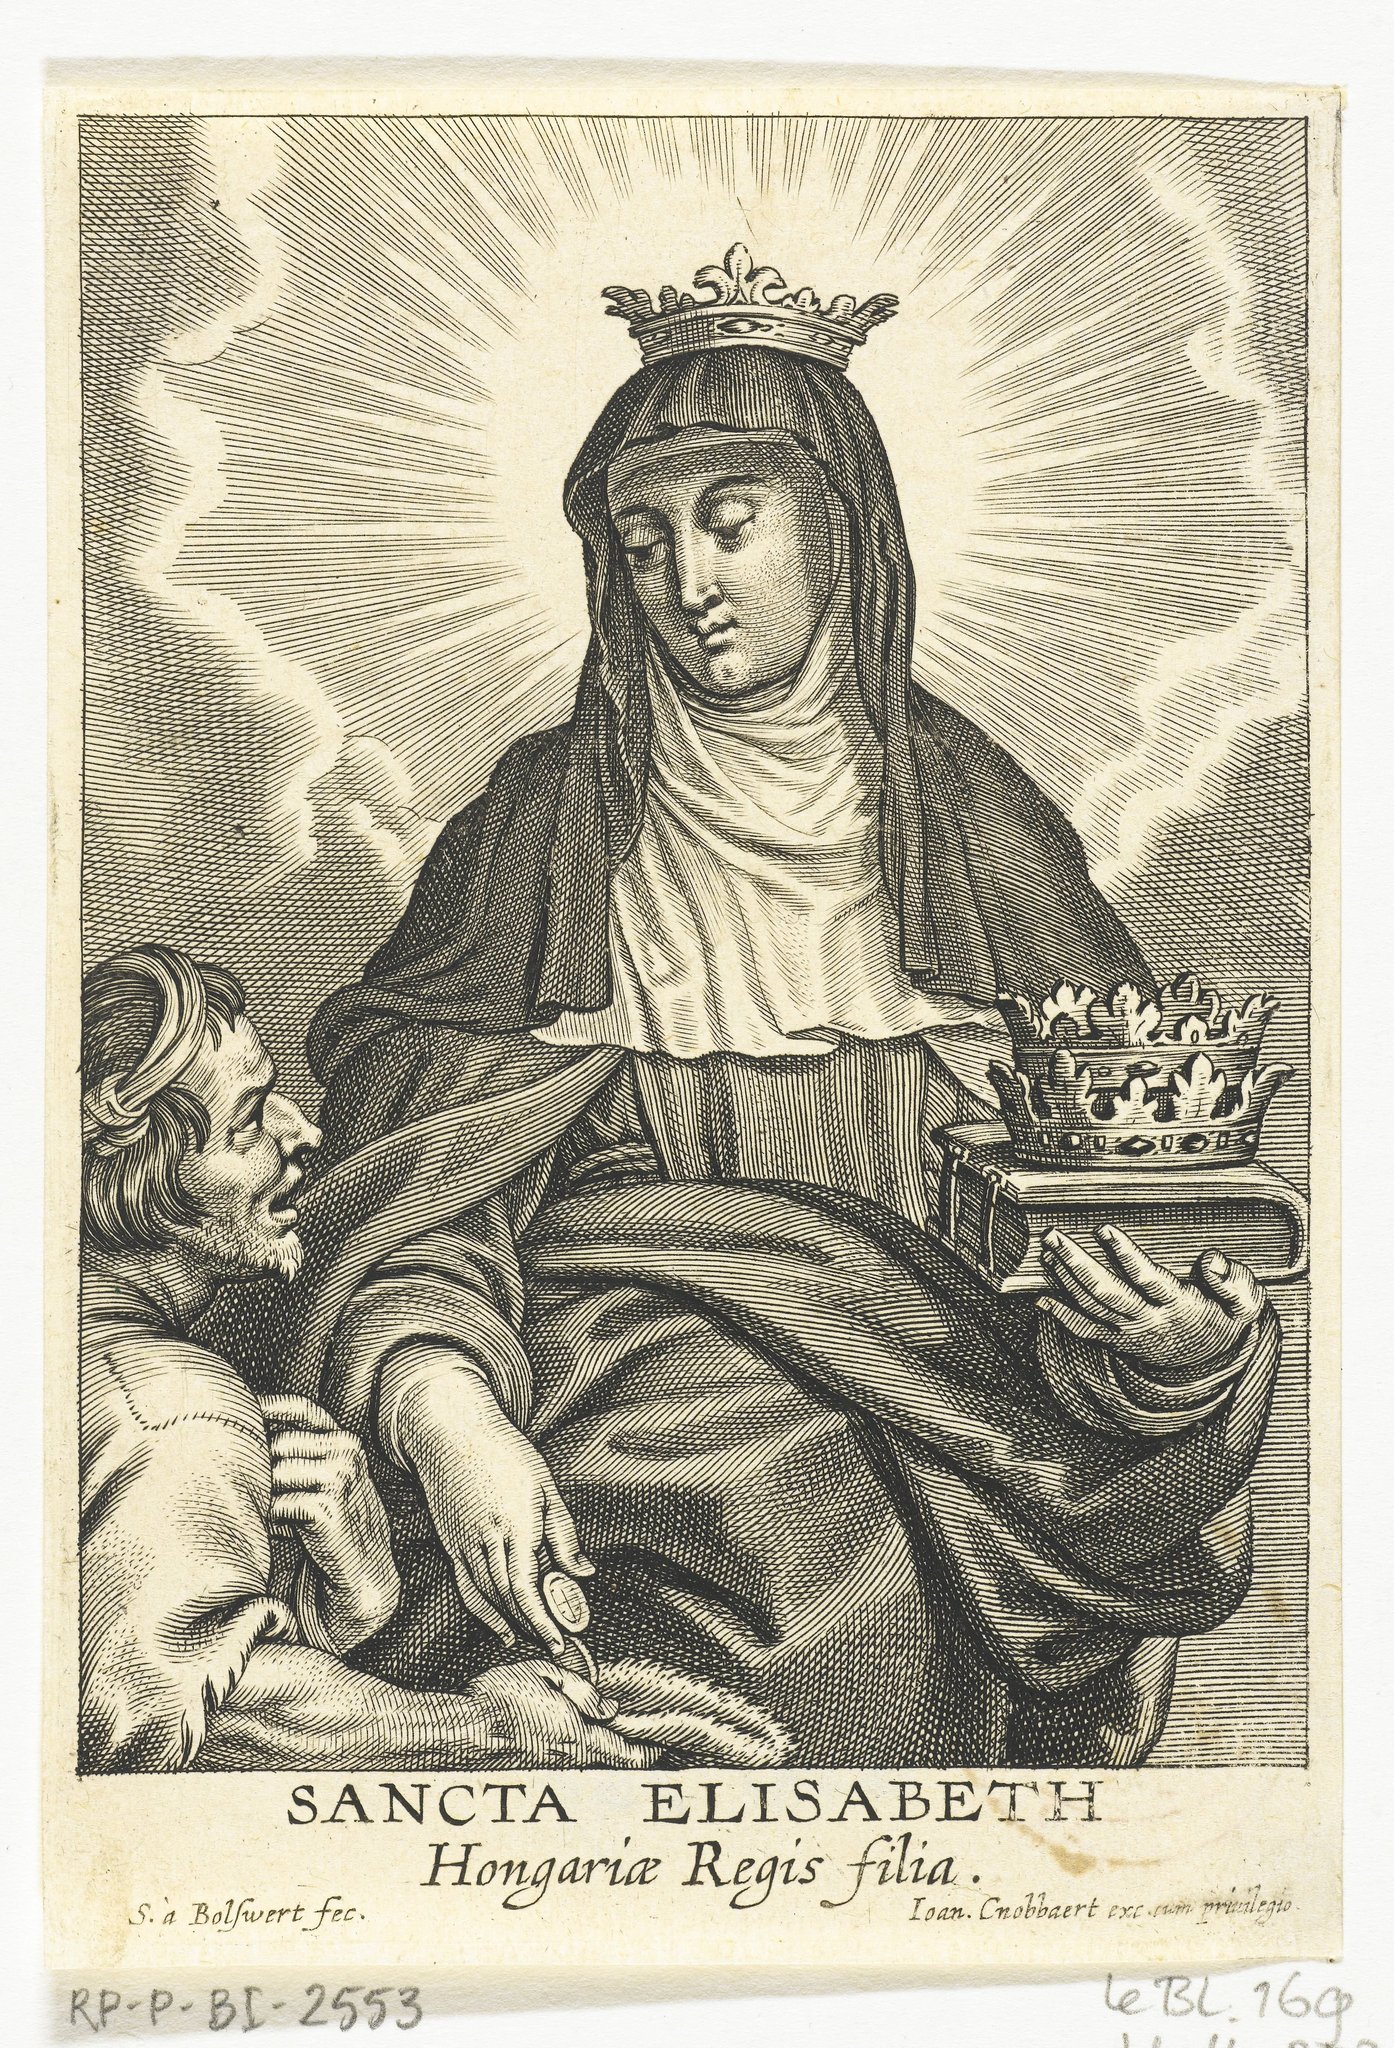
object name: print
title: Heilige Elisabeth van Hongarije geeft aalmoes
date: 1596-1659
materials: paper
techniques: engraving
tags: st. elisabeth giving alms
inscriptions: collector's mark: Lugt 240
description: Prent naar ontwerp van Peter Paul Rubens.